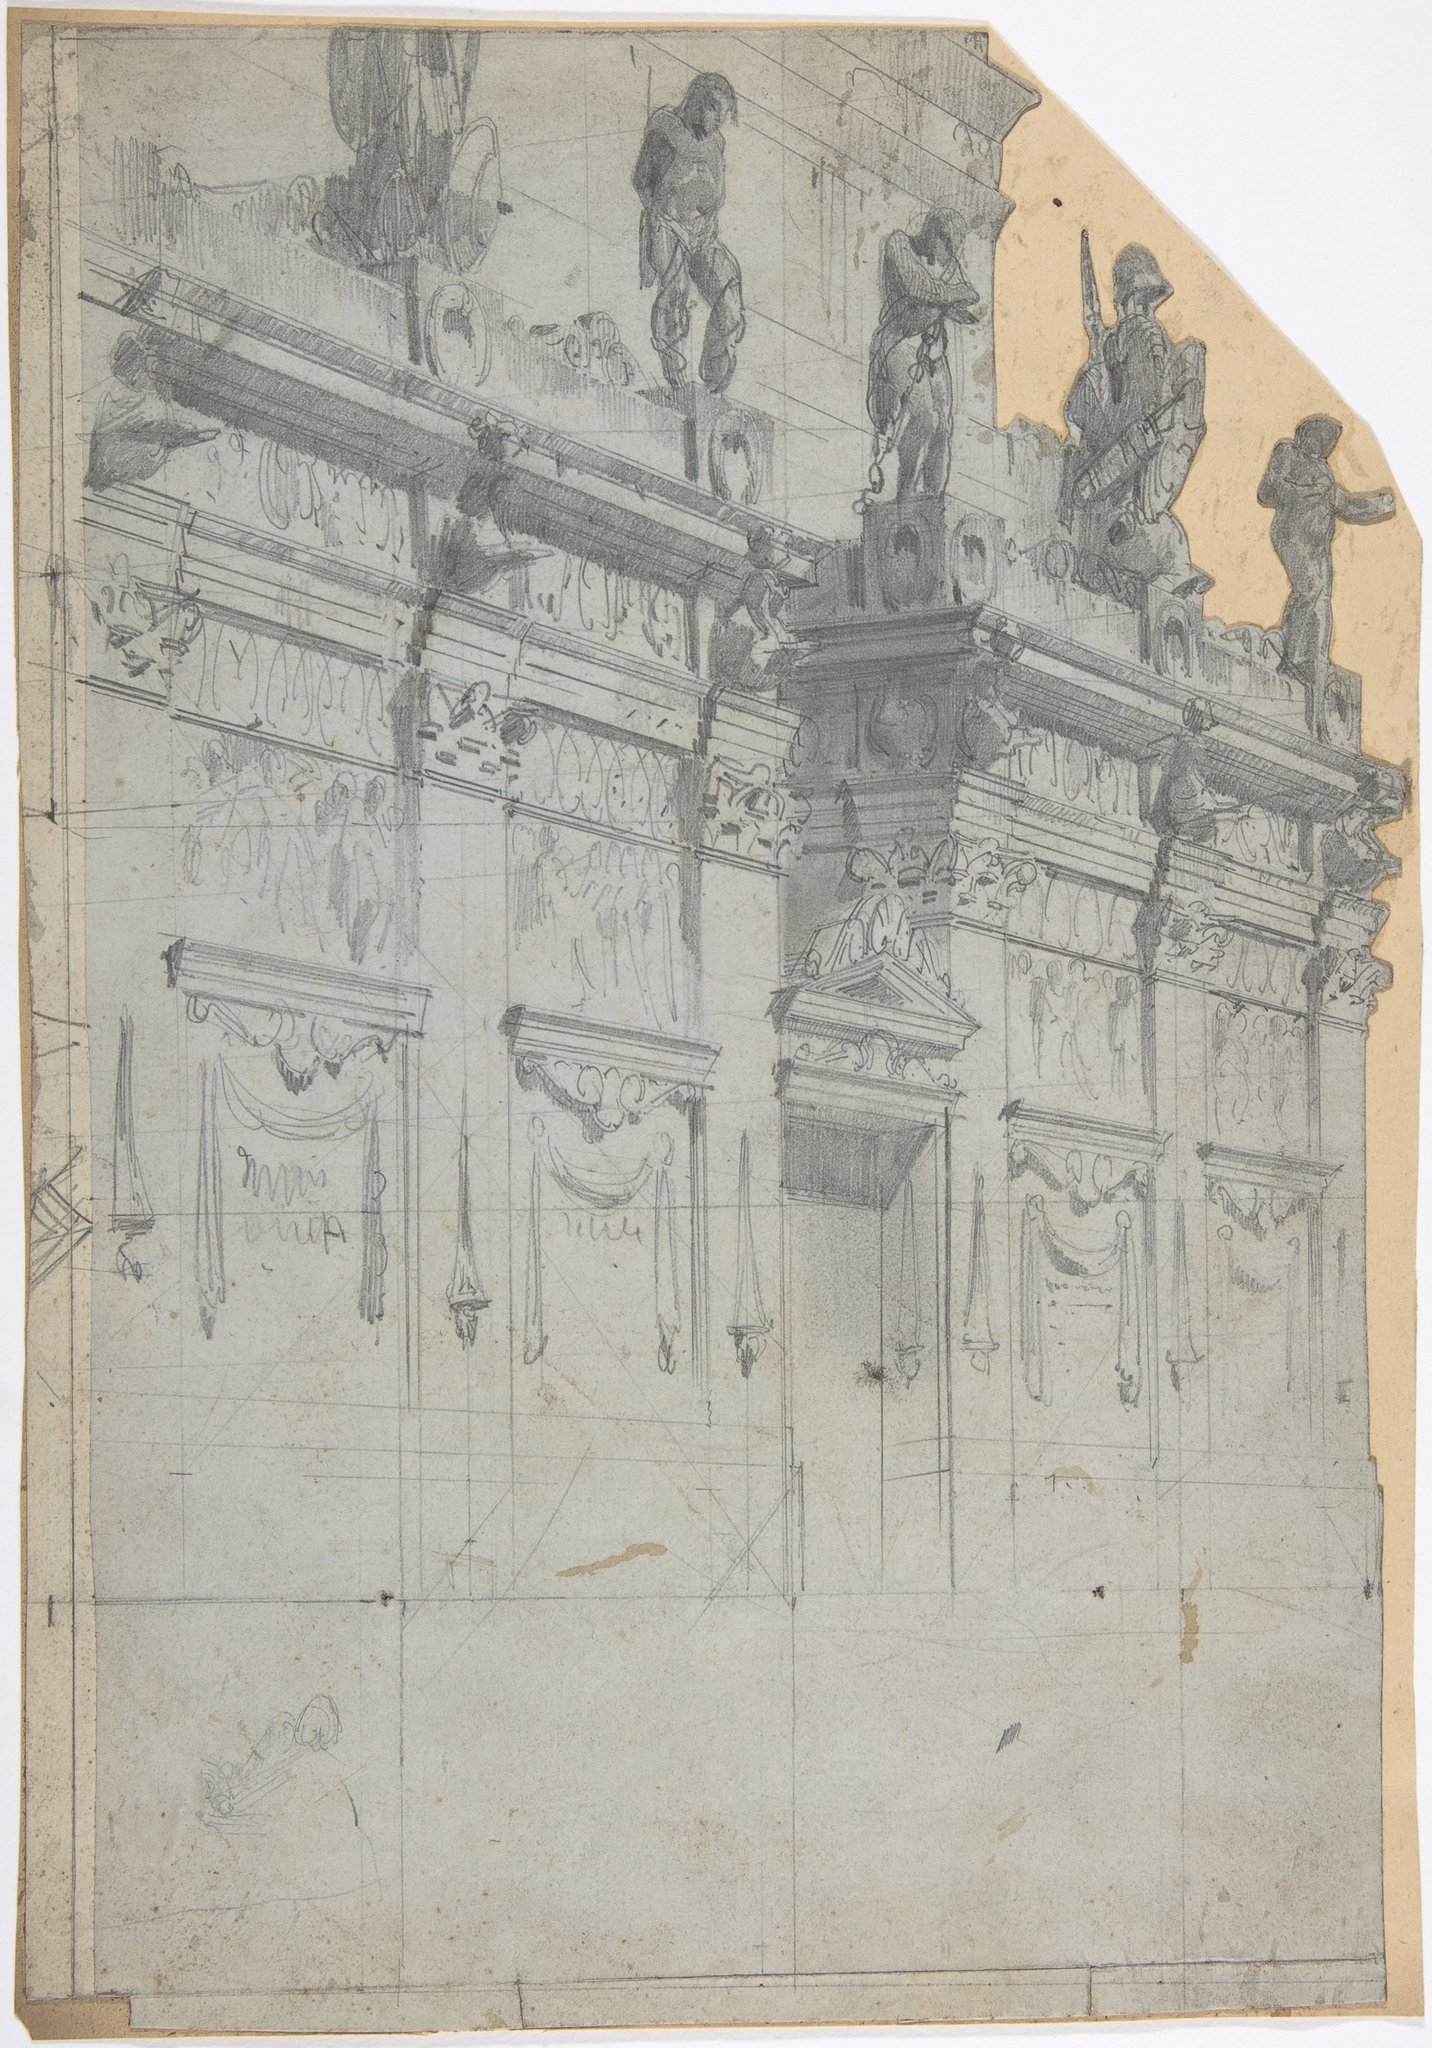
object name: drawing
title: Design for a Stage Set at the Opéra, Paris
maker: eugène cicéri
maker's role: artist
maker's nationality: french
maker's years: 1813-1890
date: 1830-1890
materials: graphite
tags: buildings,stage design